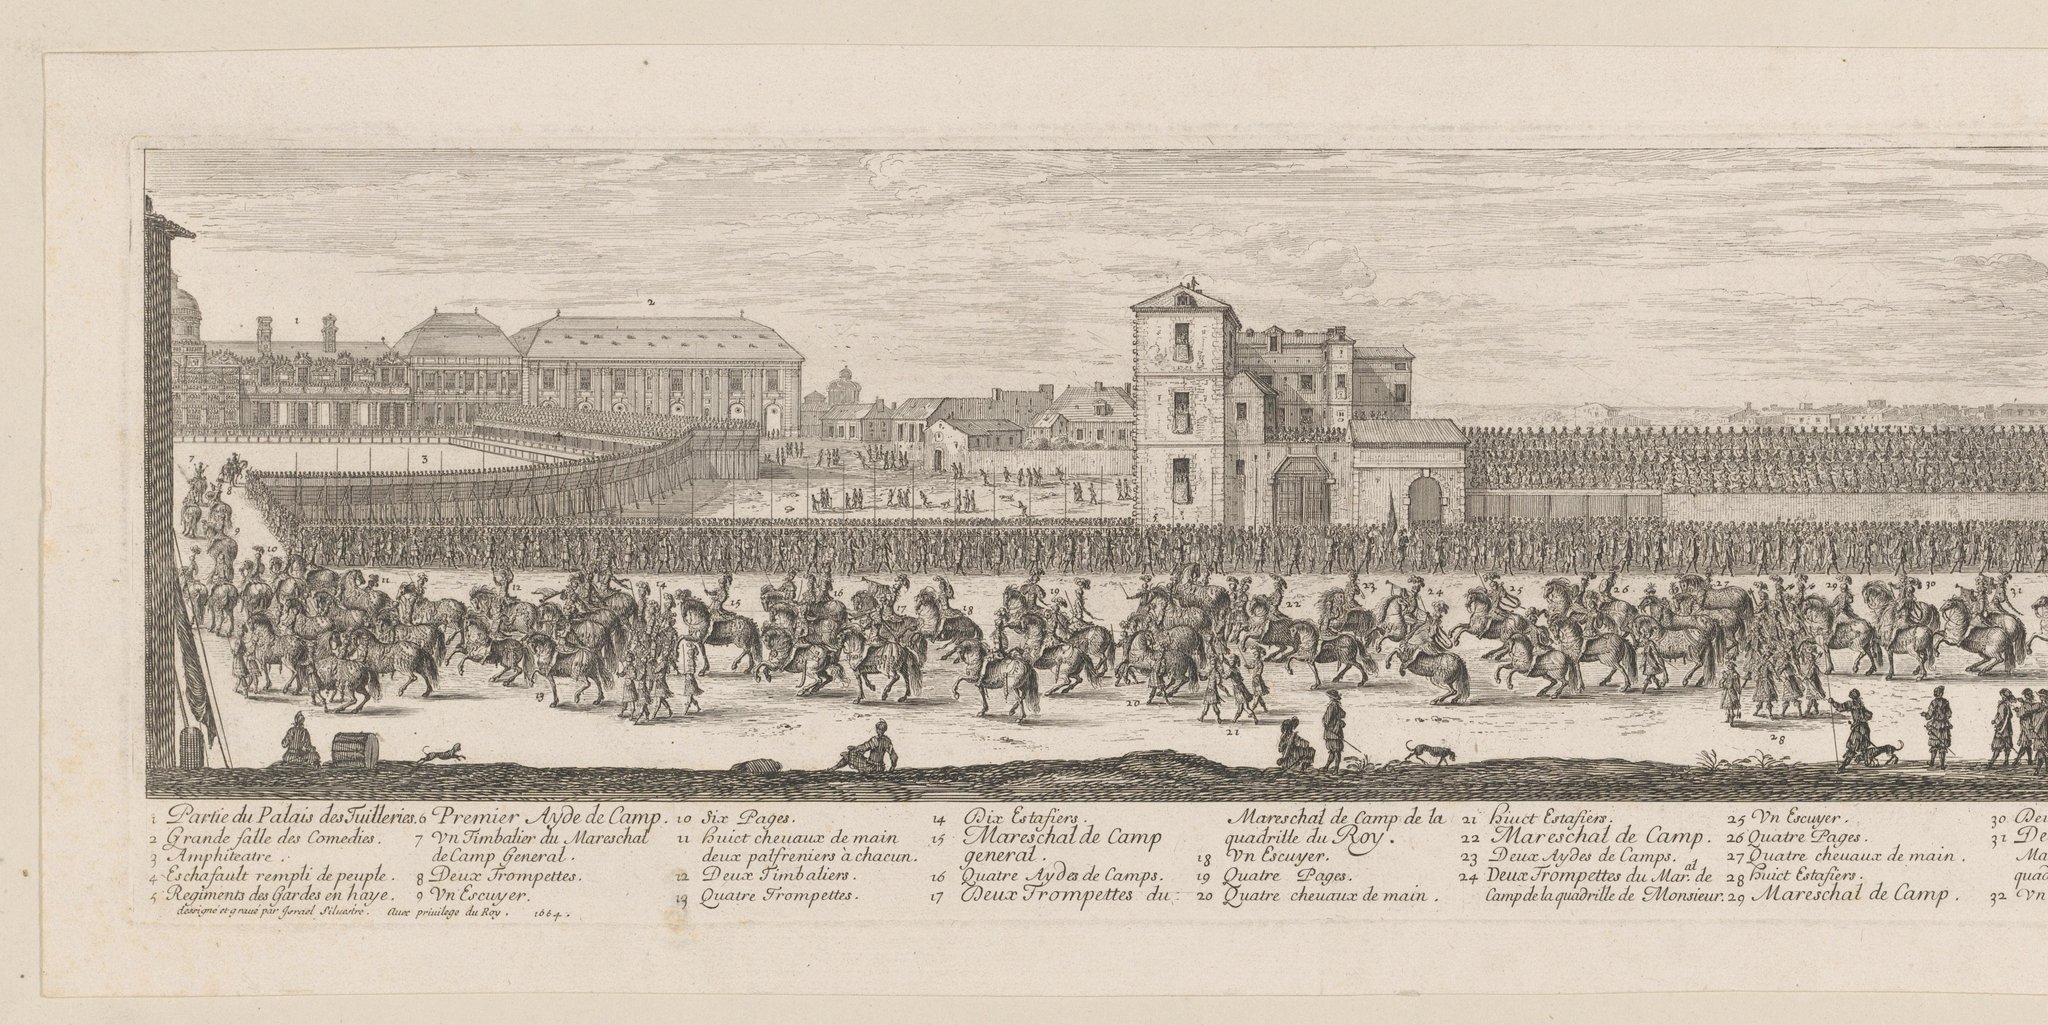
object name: print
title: Courses de Têtes et de Bagues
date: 1664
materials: paper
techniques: etching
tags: tournament, military parade, pageant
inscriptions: collector's mark: Lugt 240